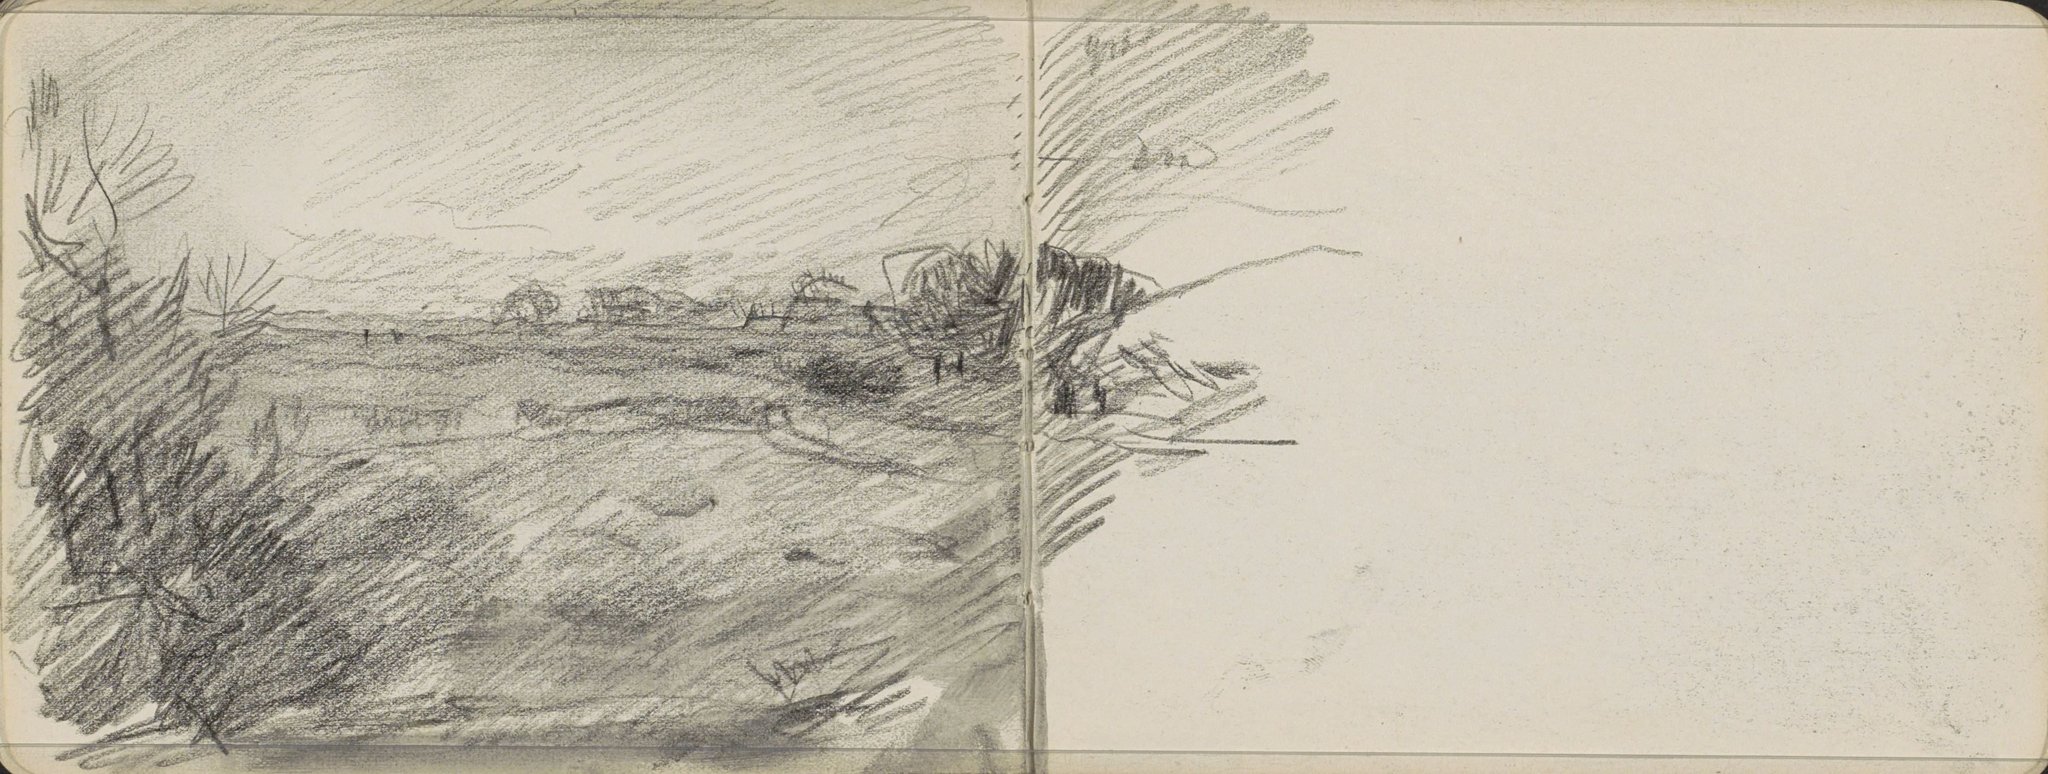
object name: sketchbook leaf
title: Landschap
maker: johan antonie de jonge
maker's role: draughtsman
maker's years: 1864-1927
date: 1884-1927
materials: chalk, paper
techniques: stumping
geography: south holland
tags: landscapes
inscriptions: kleurnotitie, handgeschreven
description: Landschap. Blad 24 verso en blad 25 recto uit een schetsboek met 33 bladen.